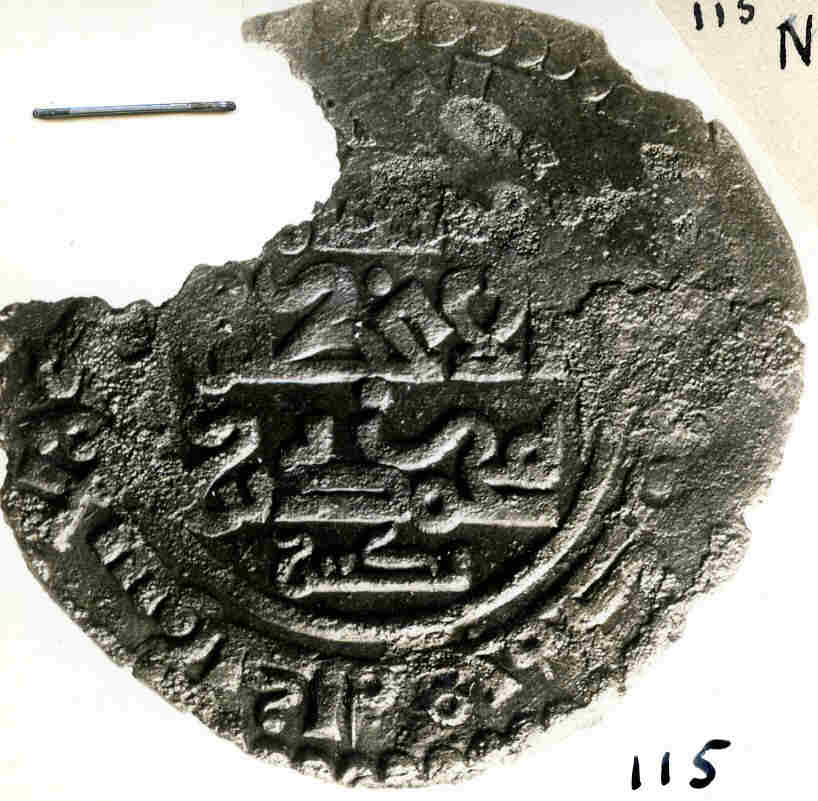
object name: coin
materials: copper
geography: iran